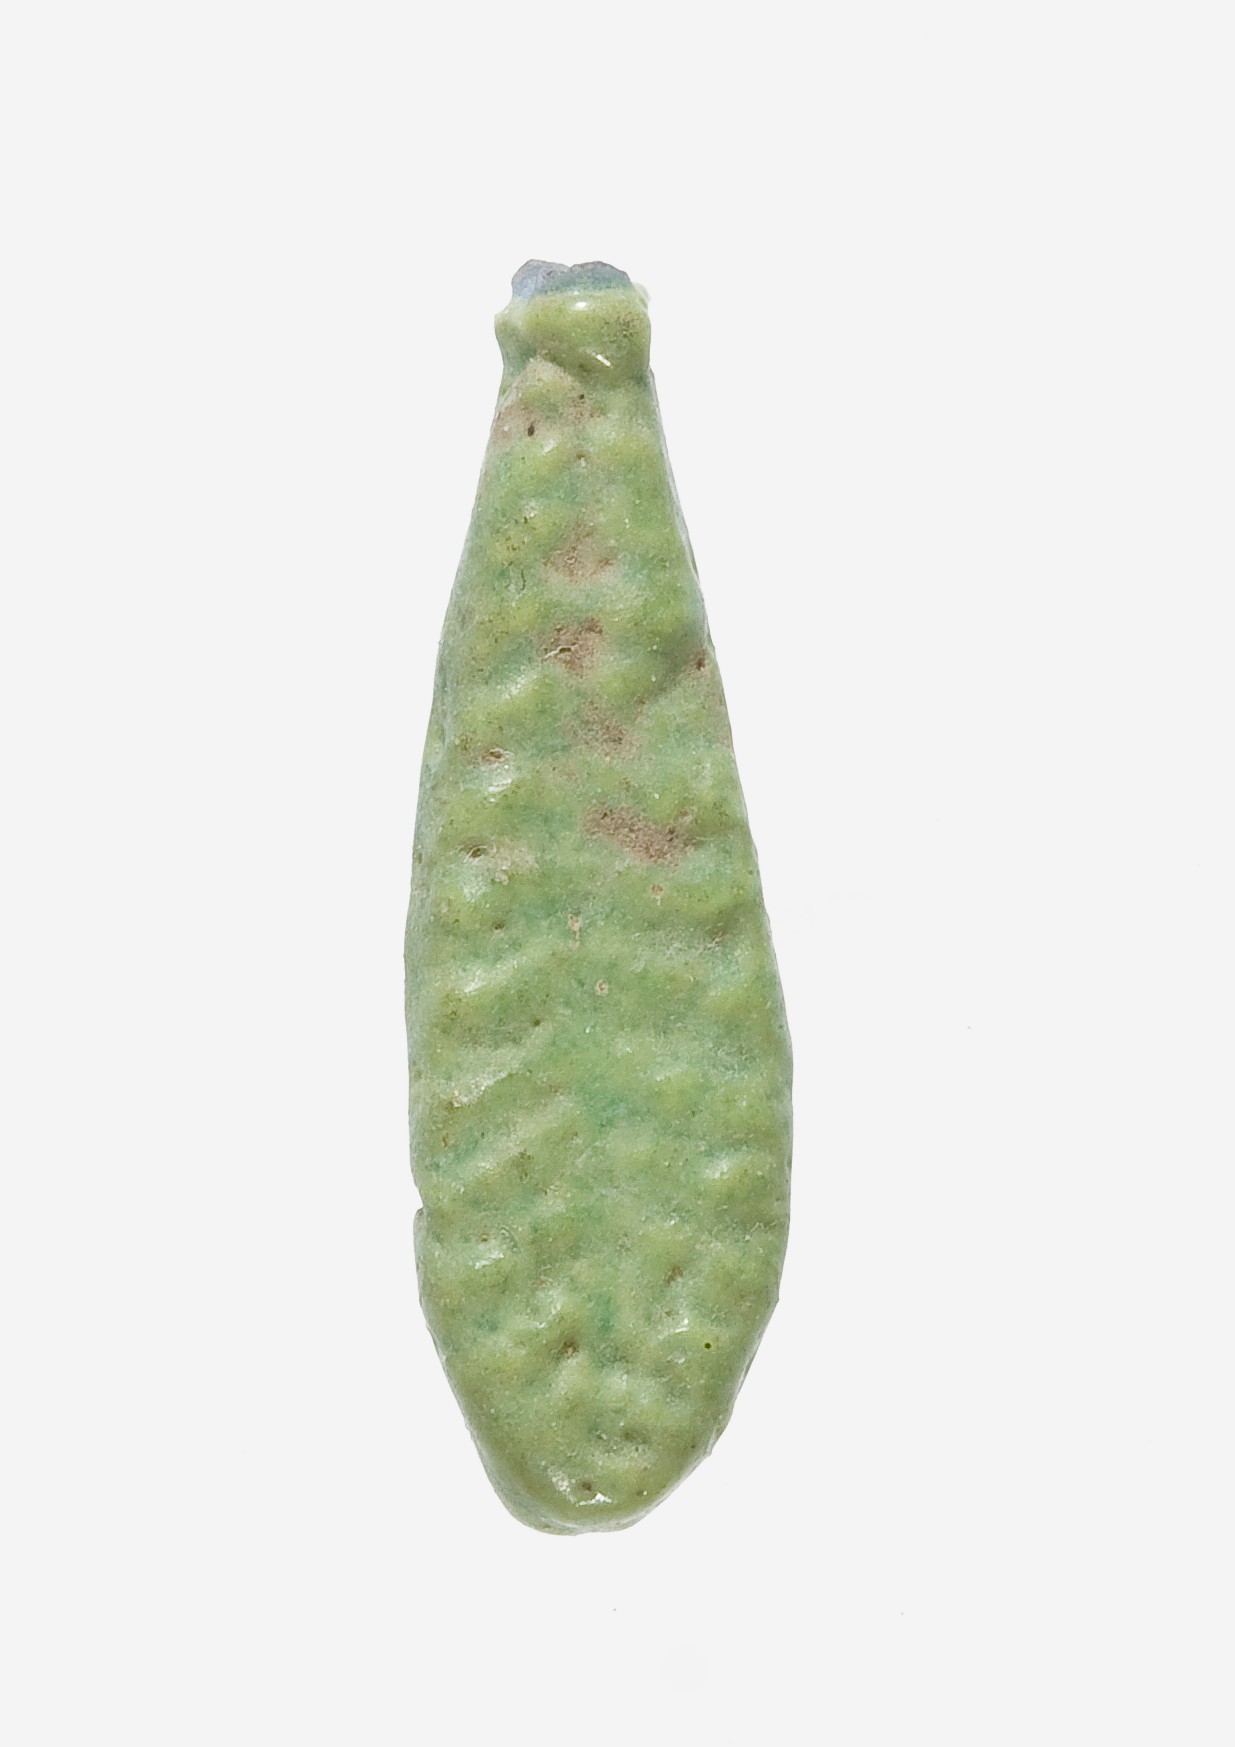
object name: pendant, leaf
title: Leaf Pendant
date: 1390-1352 BCE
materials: faience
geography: egypt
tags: leaves